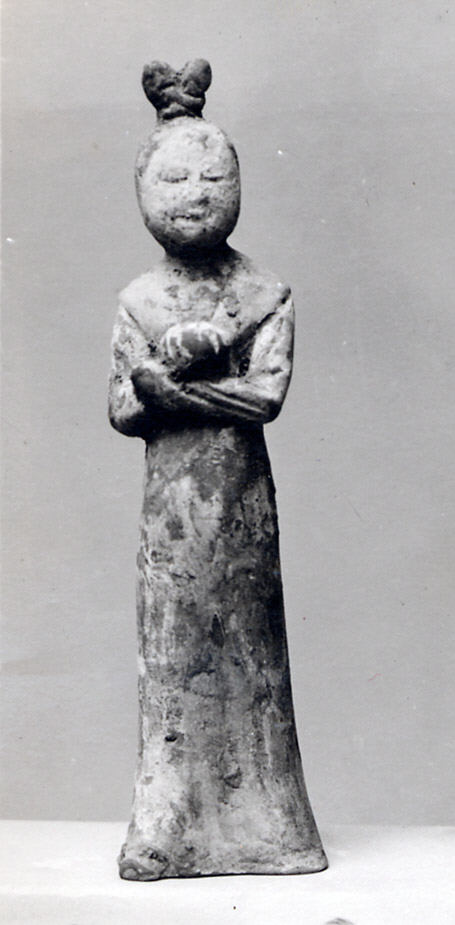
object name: figure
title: Female attendant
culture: chinese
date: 601-800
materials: earthenware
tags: women